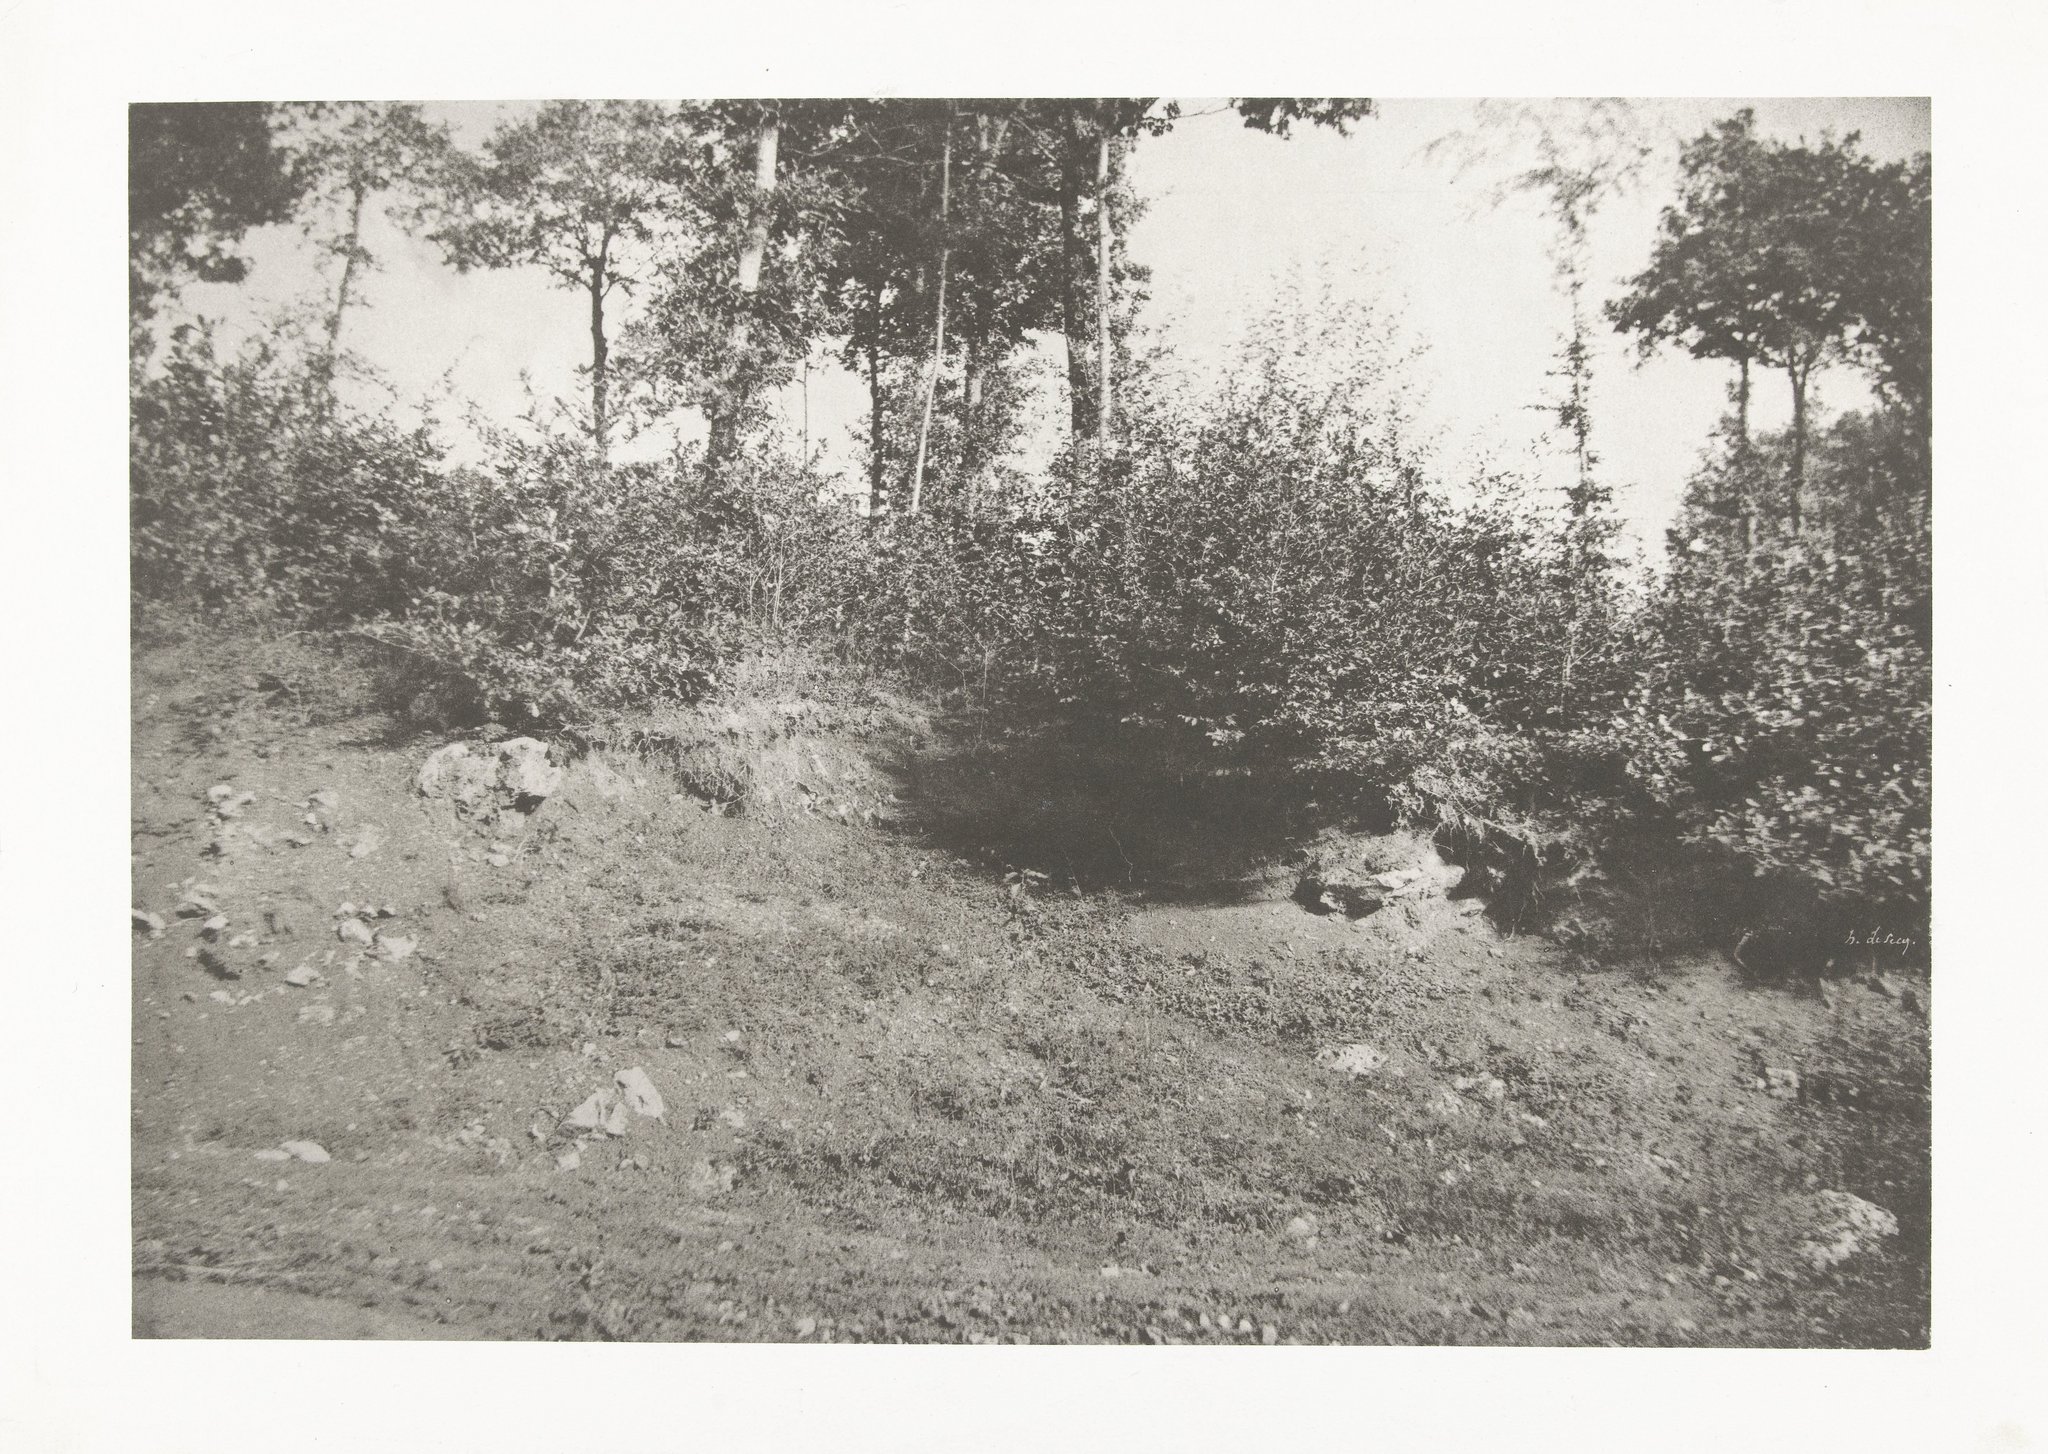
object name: photomechanical print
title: Bosschage in het woud van Montmirail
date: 1871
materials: paper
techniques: photograph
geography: france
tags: shrubs